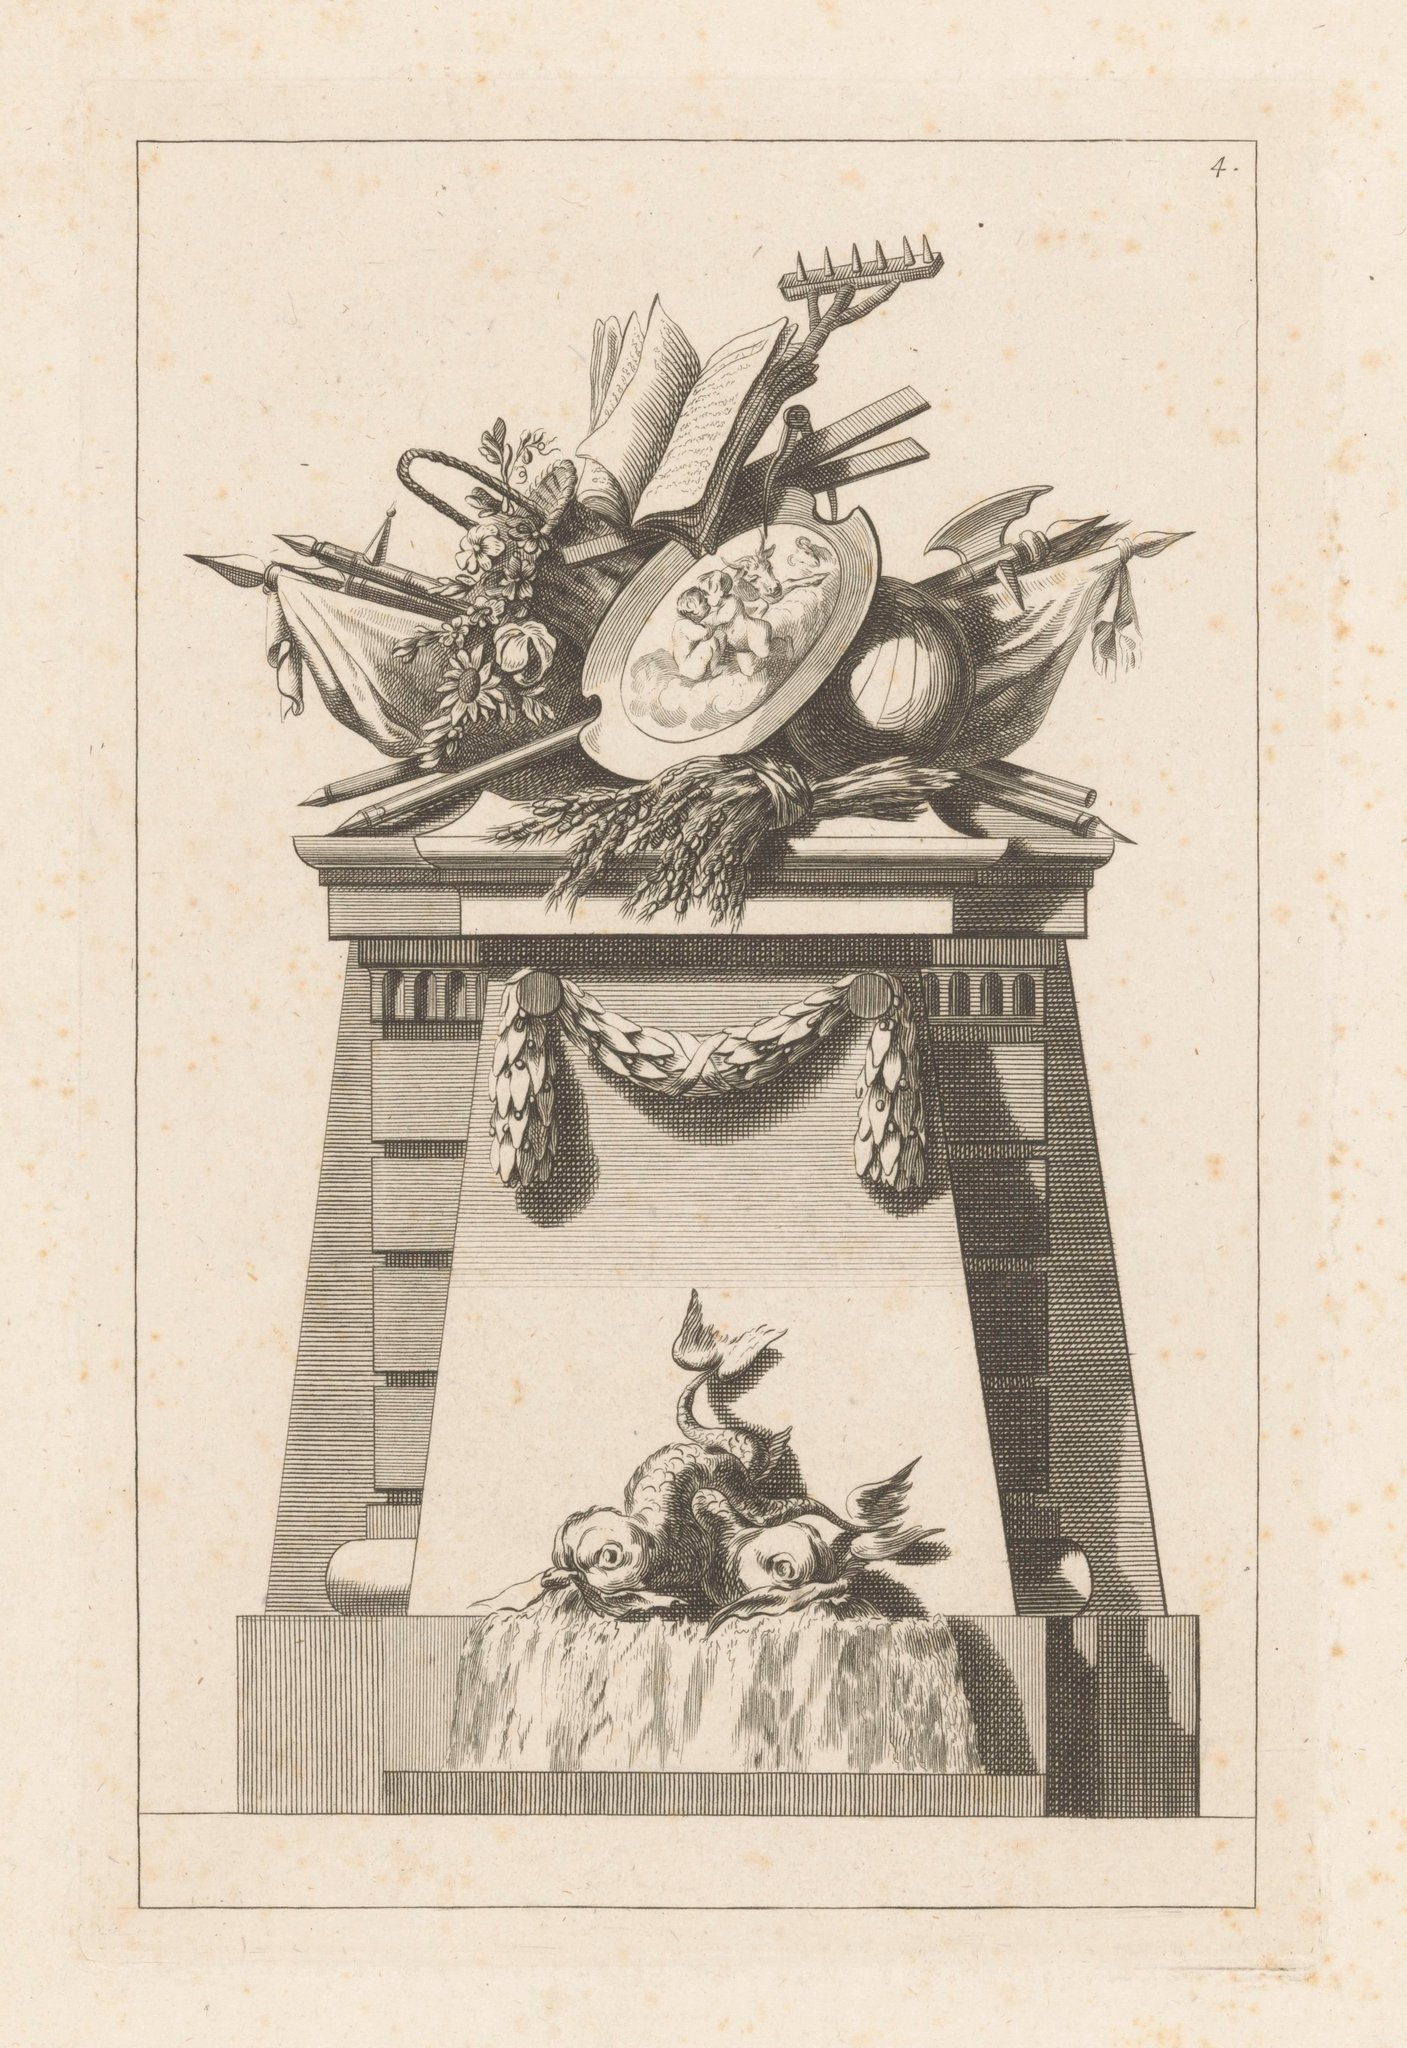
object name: ornament print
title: Fontein met dolfijnen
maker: Anonymous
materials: paper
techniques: engraving, etching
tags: dolphin ~ ornament, ornamental fountain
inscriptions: collector's mark: Lugt 2228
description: Een fontein met twee dolfijnen. Aan de bovenzijde wapens, een boek, korenaren, een mand met bloemen en een schild met putti en runderen. Rechts boven 4 genummerd.